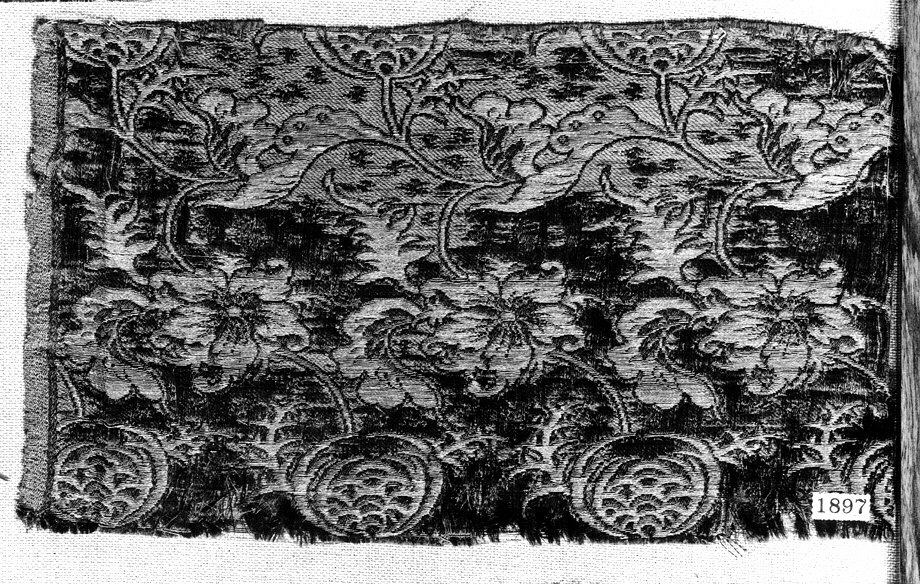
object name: piece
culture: japanese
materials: metal thread, silk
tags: leaves